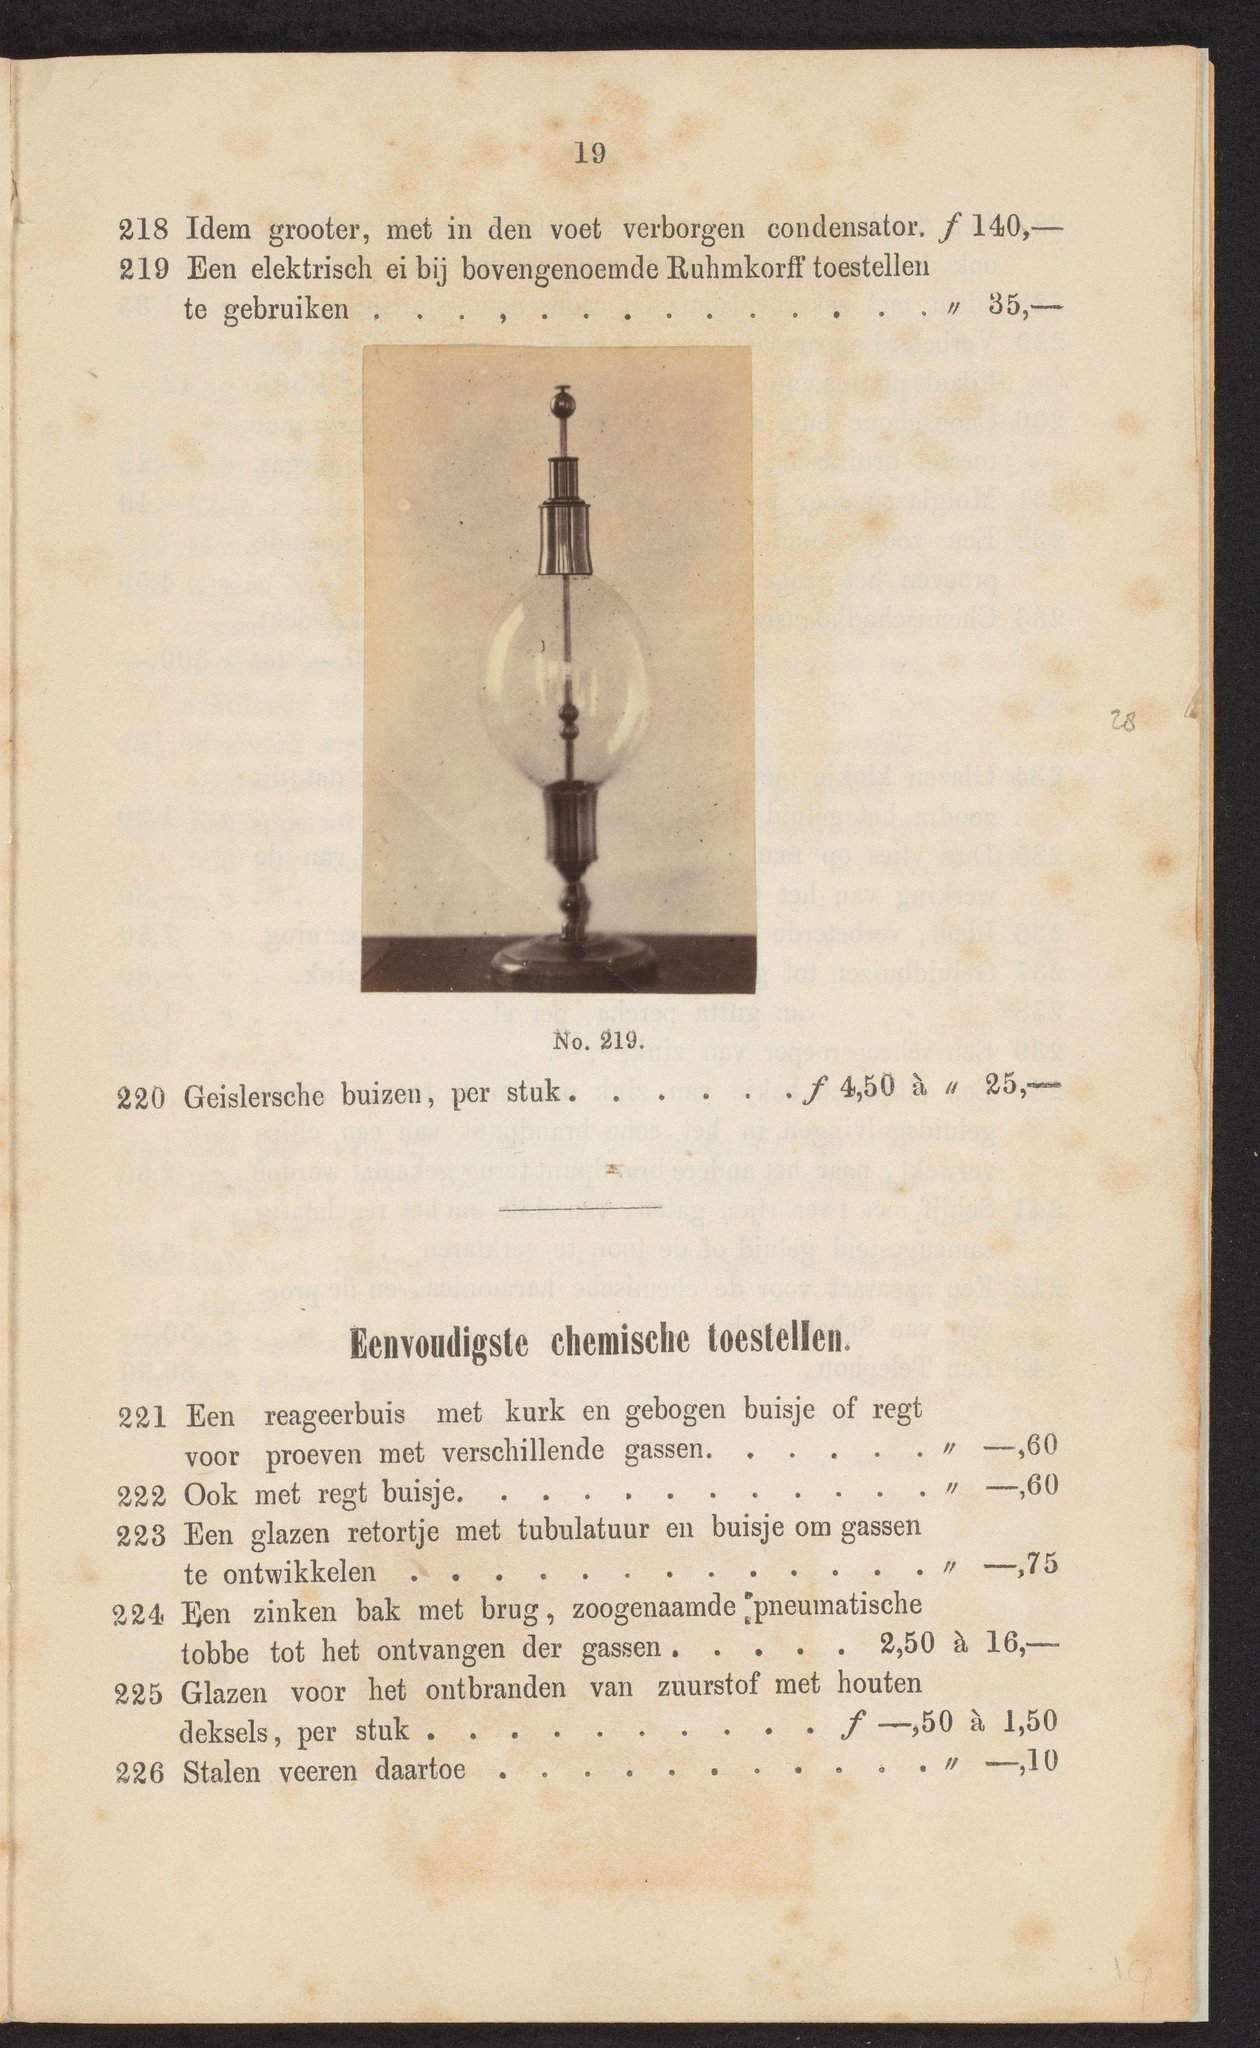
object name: page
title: Elektrisch ei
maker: fredrich wilhelm funckler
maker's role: instrument maker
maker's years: 1836-1886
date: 1857-1867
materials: photographic support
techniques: albumen print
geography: netherlands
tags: physics (+ tools, instruments; laboratory equipment ~ scientific research)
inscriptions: number: ‘No. 219.’